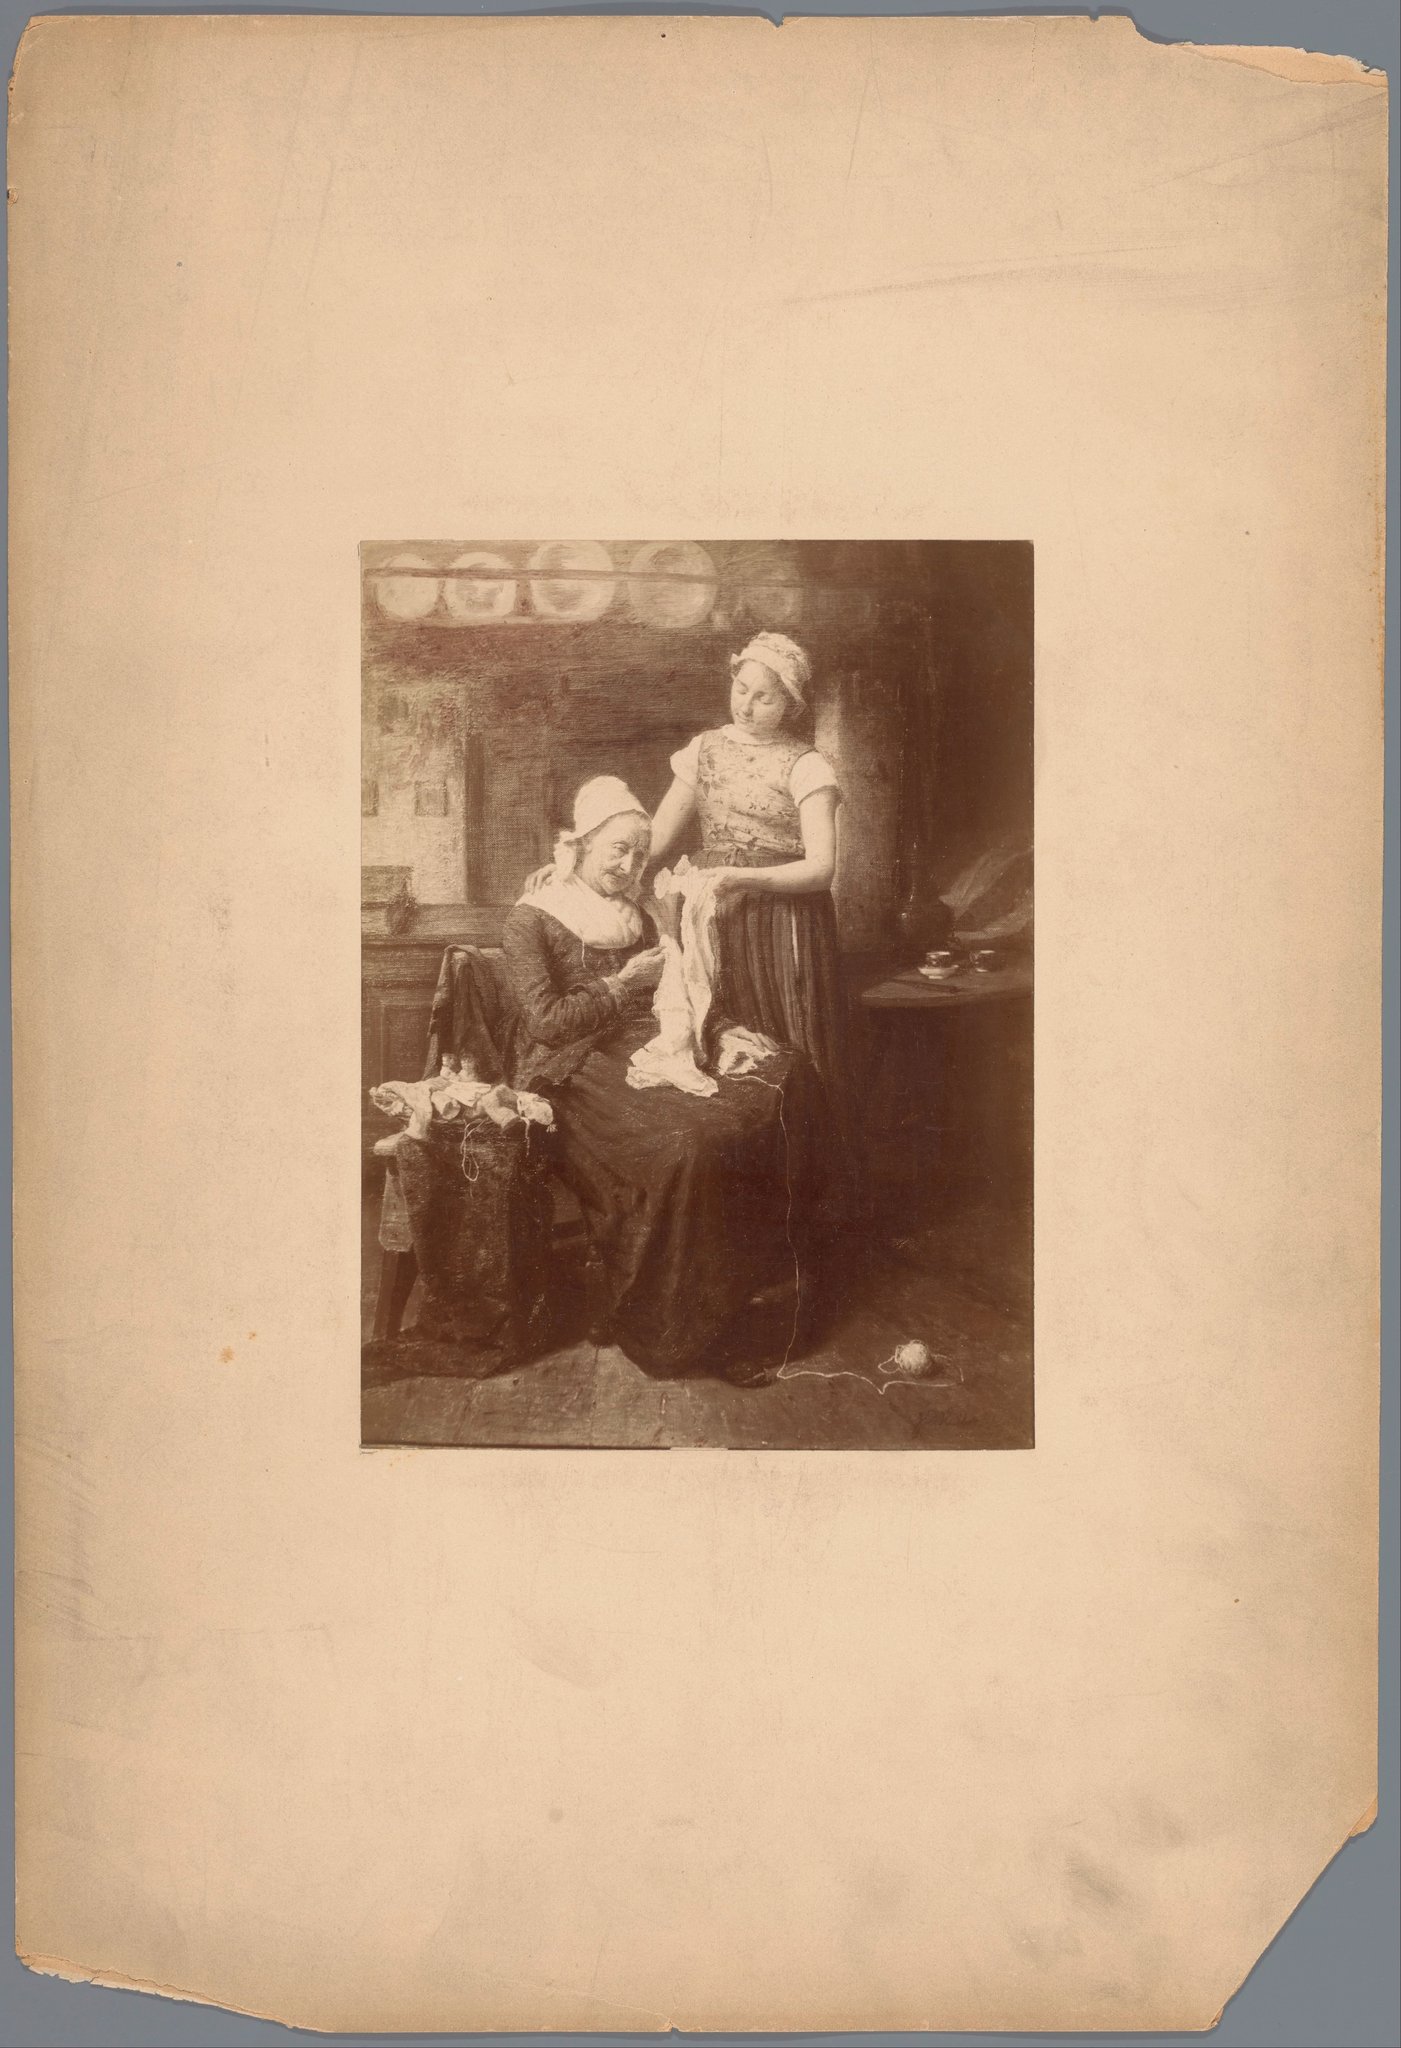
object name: photograph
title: Fotoreproductie van een schilderij, voorstellende (vermoedelijk) een breiende oude vrouw en een staande jonge vrouw in een interieur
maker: Anonymous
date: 1875-1900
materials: cardboard, photographic support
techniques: albumen print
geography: europe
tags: (ball of) yarn, old woman, interior of the house, (other forms of) needlework, e.g.: crocheting, knitting, embroidering, europe